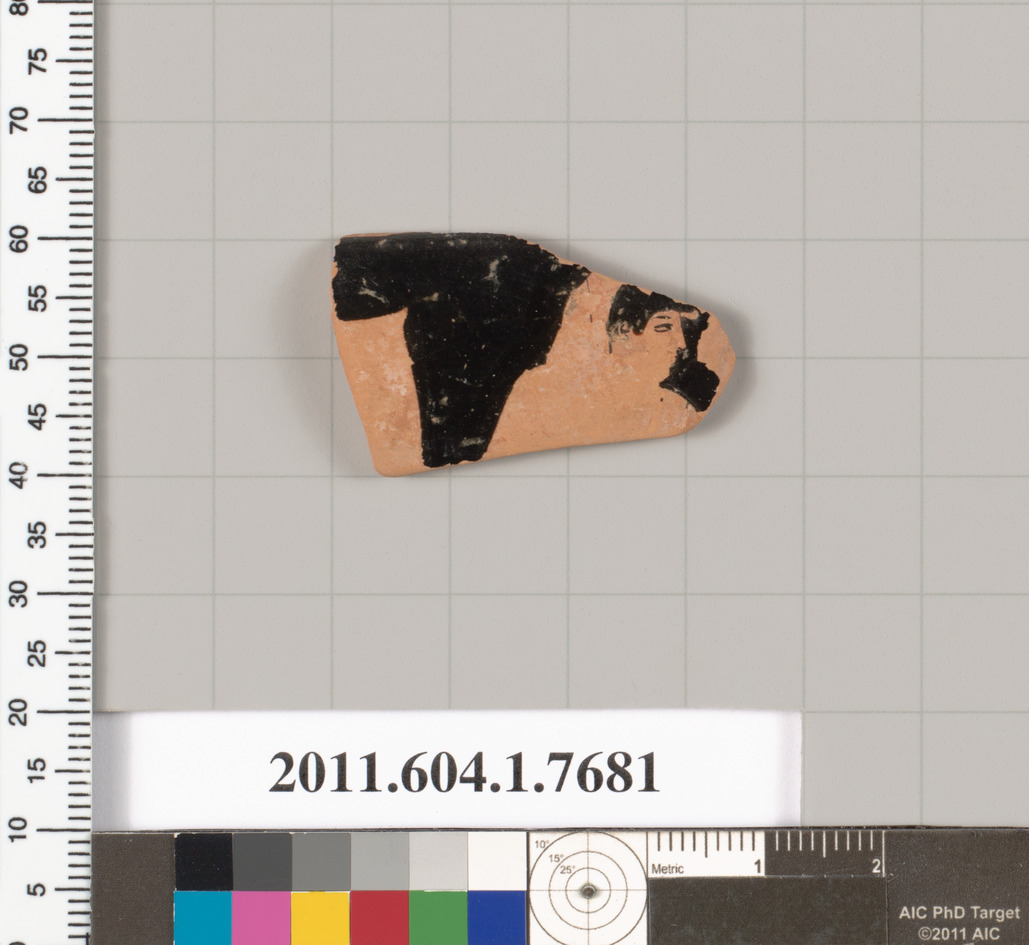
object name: kylix fragment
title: Terracotta rim fragment of a kylix (drinking cup)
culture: greek, attic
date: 470-460 BCE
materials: terracotta